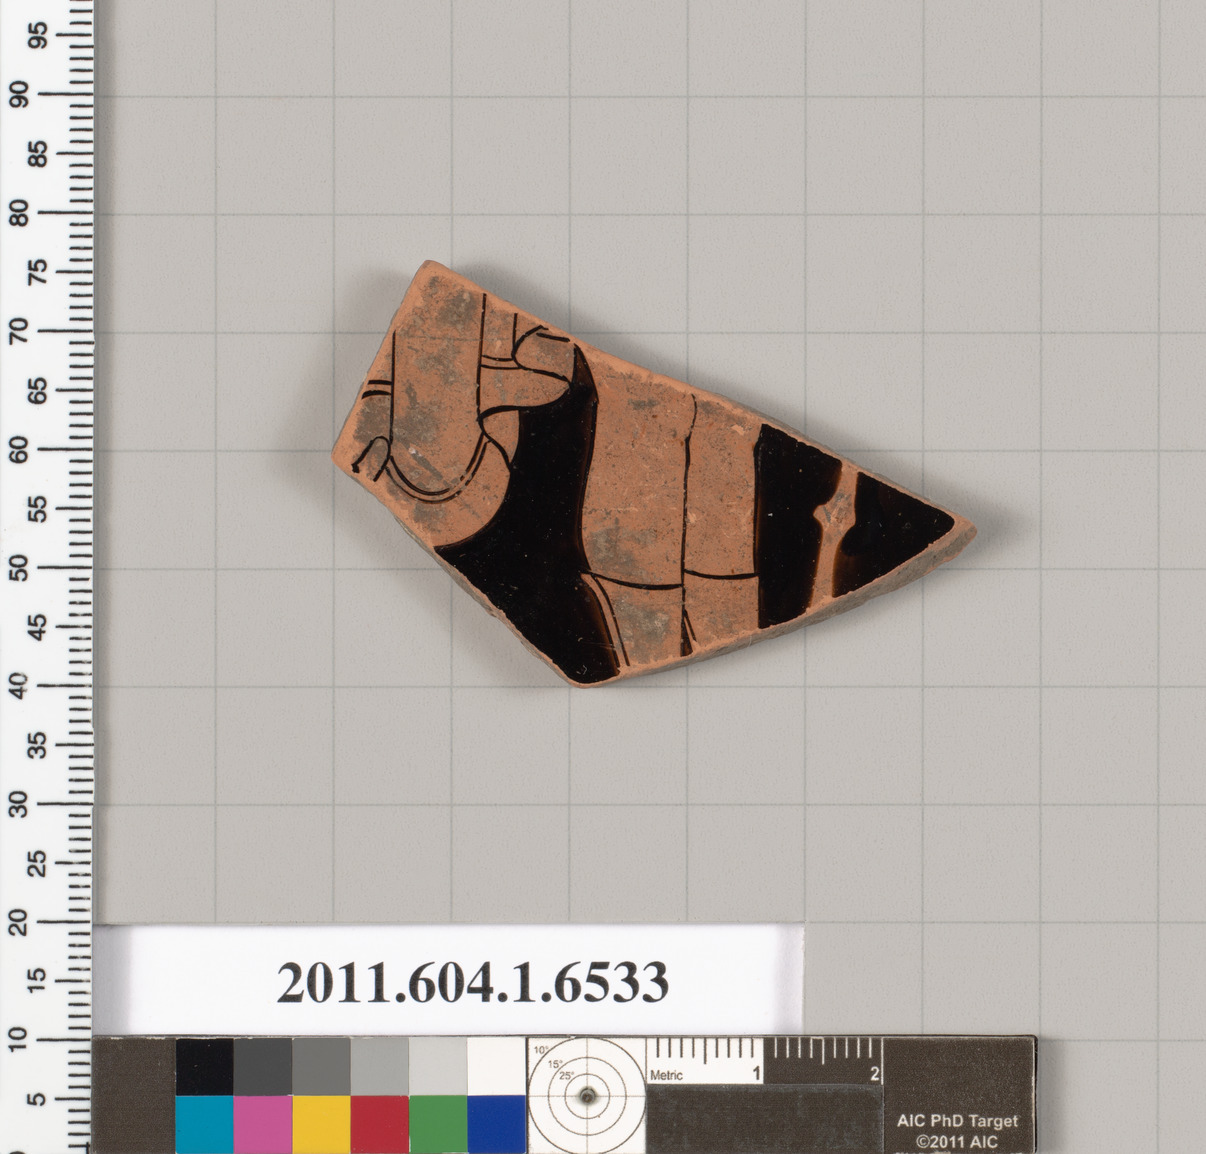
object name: kylix fragment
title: Terracotta fragment of a kylix (drinking cup)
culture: greek, attic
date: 490-480 BCE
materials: terracotta